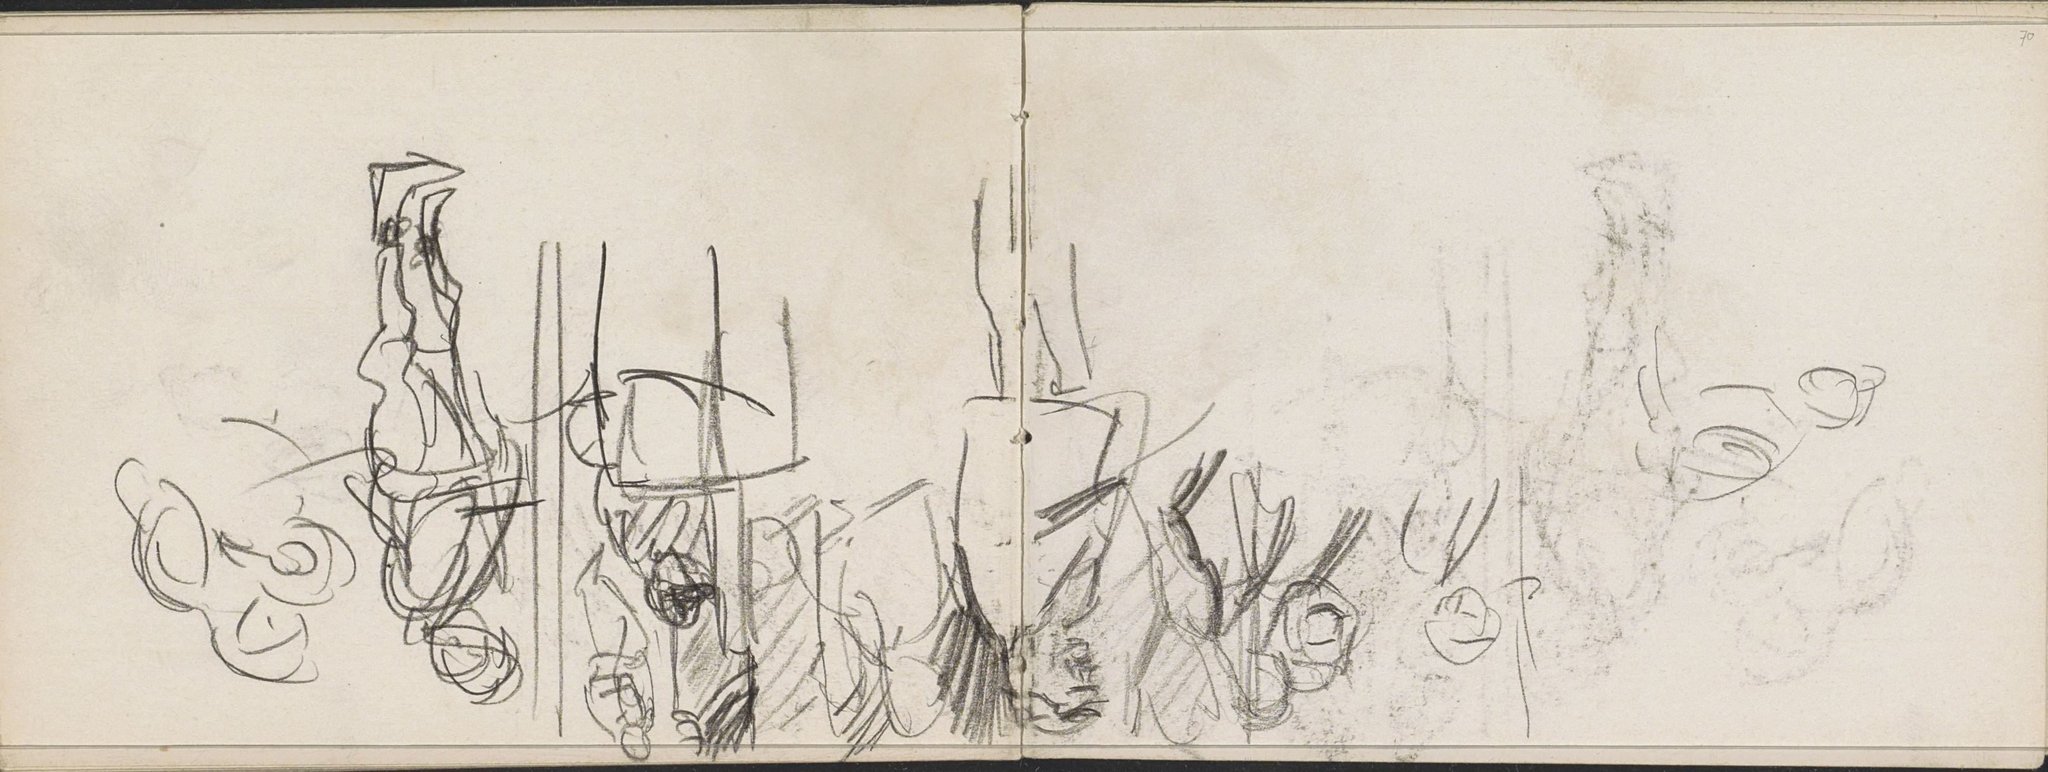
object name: sketchbook leaf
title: Figuurstudies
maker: isaac israels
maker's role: draughtsman, painter, print maker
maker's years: 1865-1934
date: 1875-1934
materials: chalk, paper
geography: paris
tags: adult woman, adult man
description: Pagina 69 en pagina 70 uit schetsboek XLV met 85 pagina's.